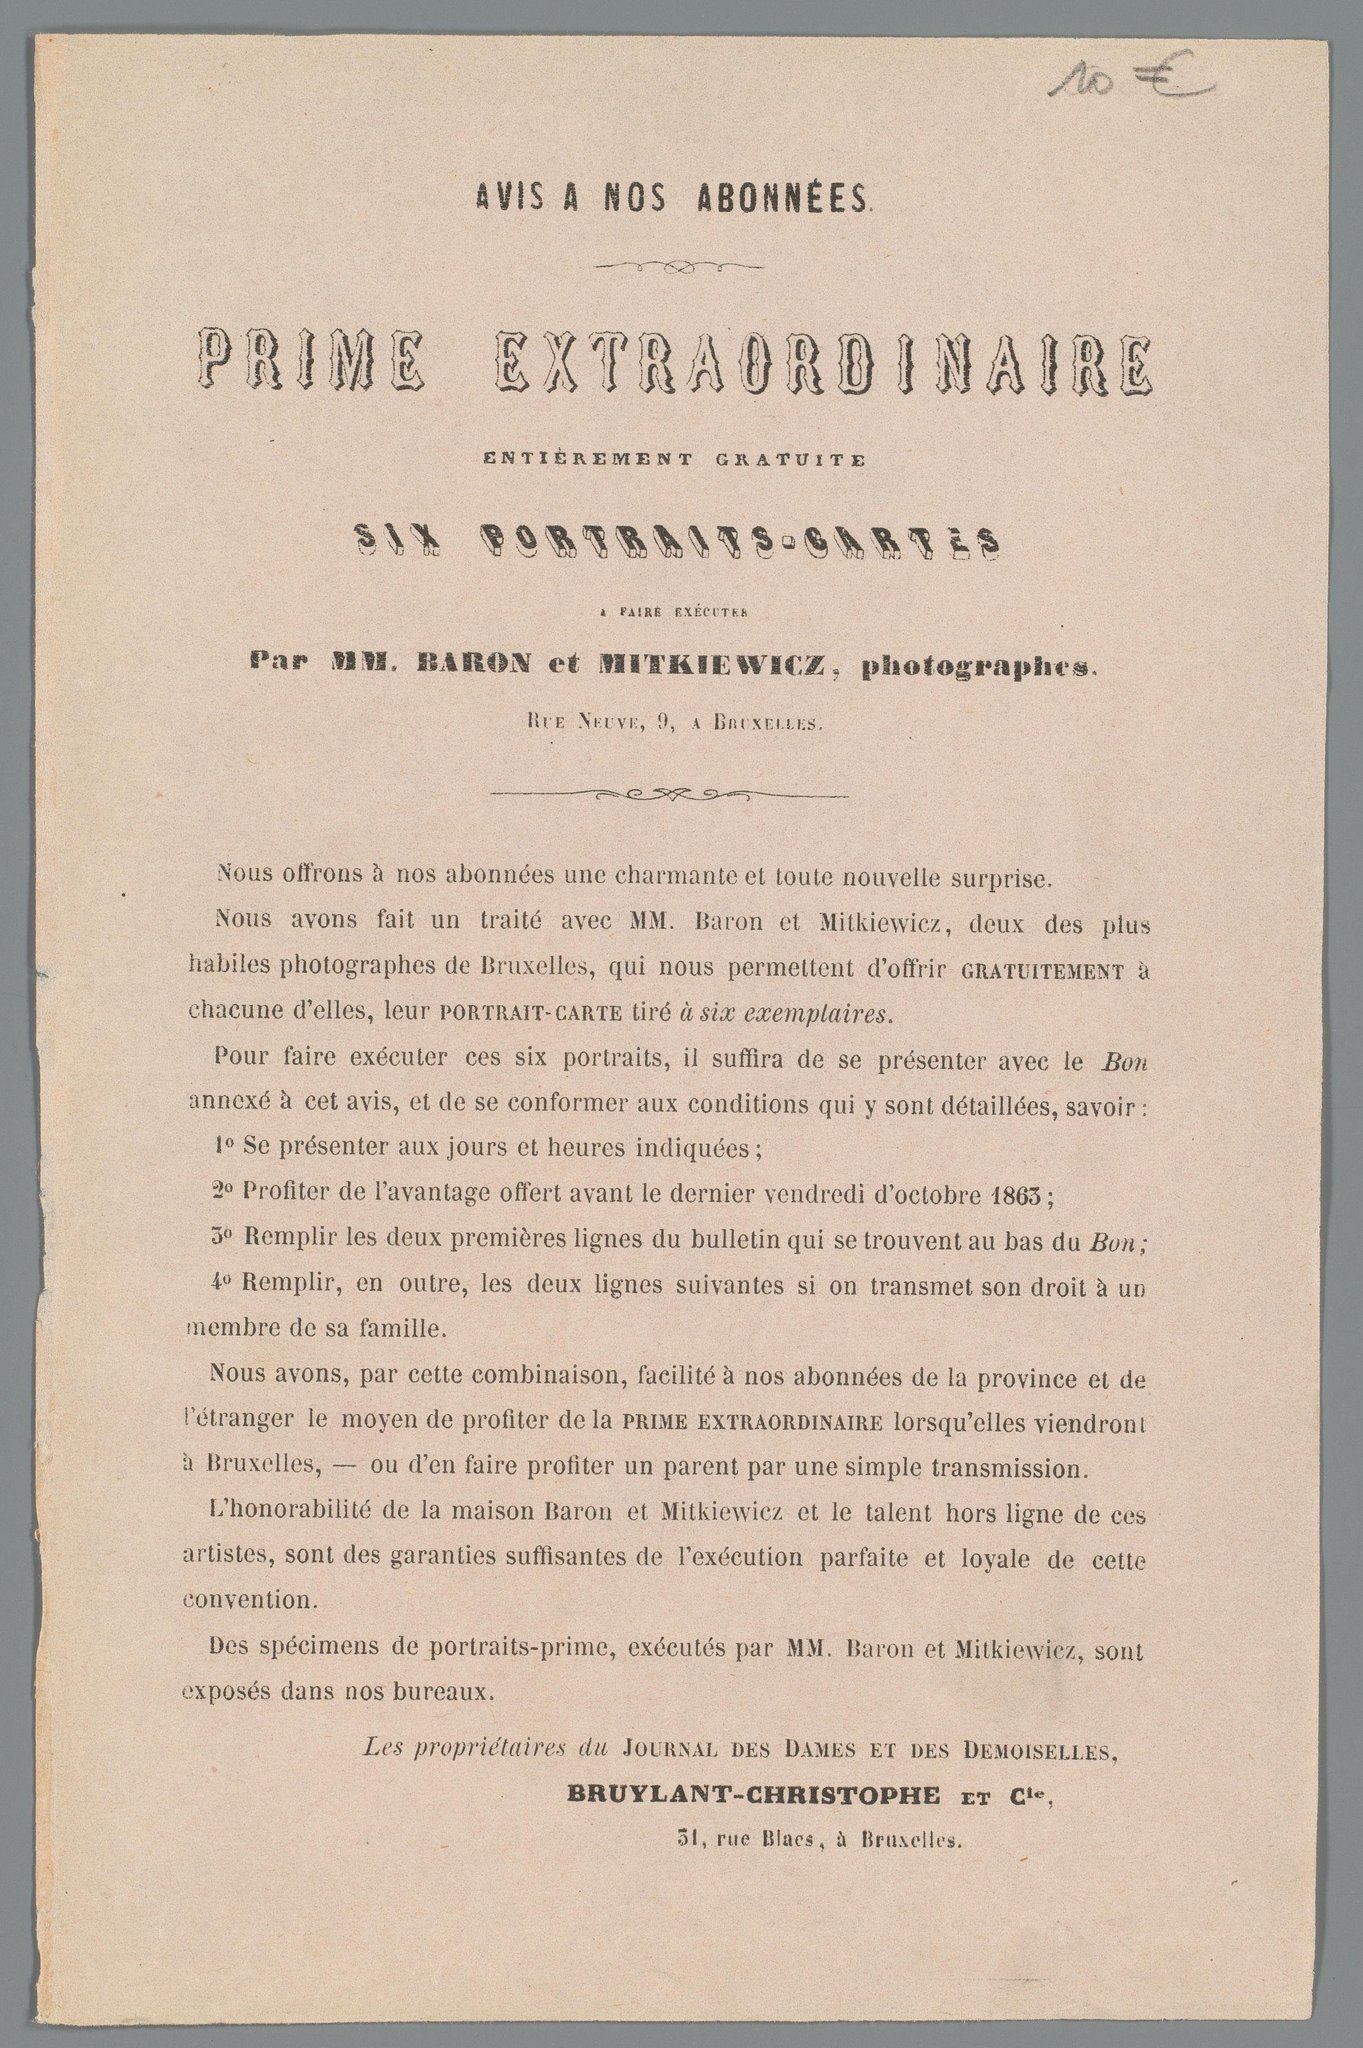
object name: document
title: Aanbod voor een gratis fotoportret voor abonnees van het modetijdschrift Journal des Dames et des Demoiselles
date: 1873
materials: paper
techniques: printing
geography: brussels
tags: photography, printed matter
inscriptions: inscription: ‘10€’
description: Aanbod voor een gratis fotoportret voor abonnees van het modetijdschrift Journal des Dames et des Demoiselles (1841-1902) te vervaardigen door de fotostudio Baron en Mitkiewicz. Van het gemaakte portret krijgt de abonnee zes afdrukken.